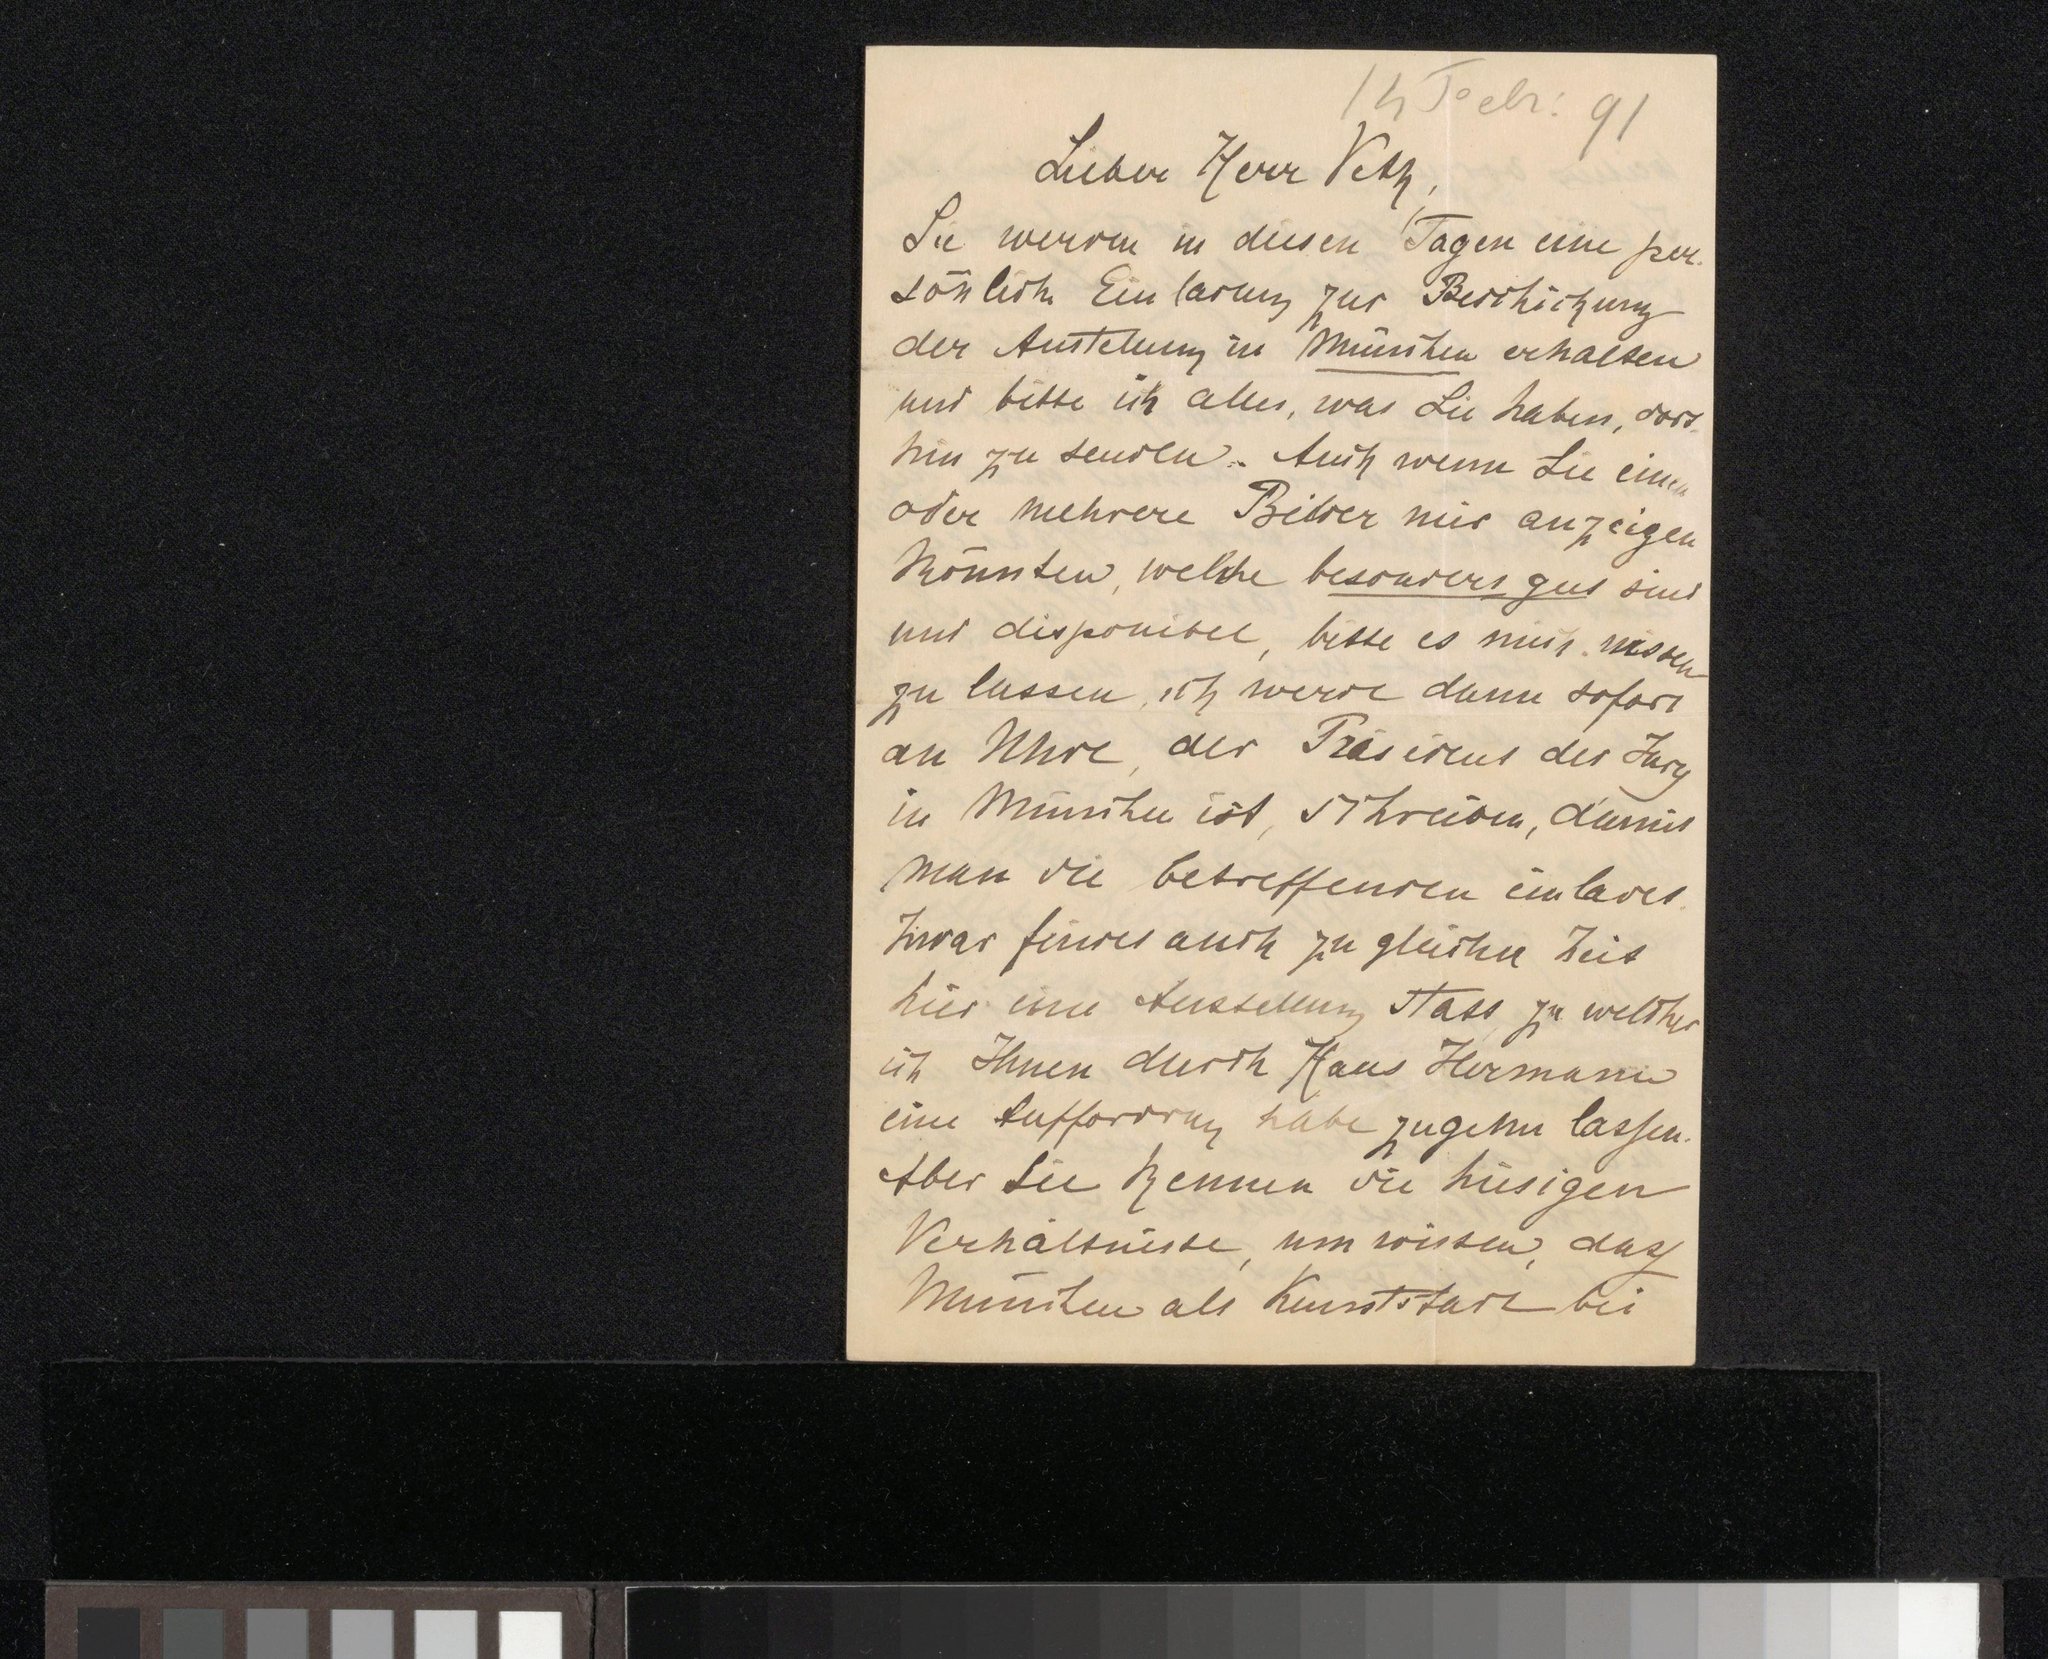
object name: letter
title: Brief aan Jan Veth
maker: max liebermann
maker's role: draughtsman, print maker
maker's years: 1847-1935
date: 1891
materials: ink, paper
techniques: pen, writing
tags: jozef israëls, rotterdam, george hendrik breitner, dordrecht, amsterdam, designer, jan veth, arnhem, anton mauve, the hague, painter, jacob maris, isaac israels, karl stauffer, wilhelm von bode, publisher, j.h. schorer, hans herrmann, exhibition ~ art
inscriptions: collector's mark: ‘RPK’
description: Opgenomen in: Ernst Braun, Max Liebermann: Briefe 1869-1895, Baden-Baden: Deutscher Wissenschafts-Verlag, 2011, Band 1, p. 1174-175.